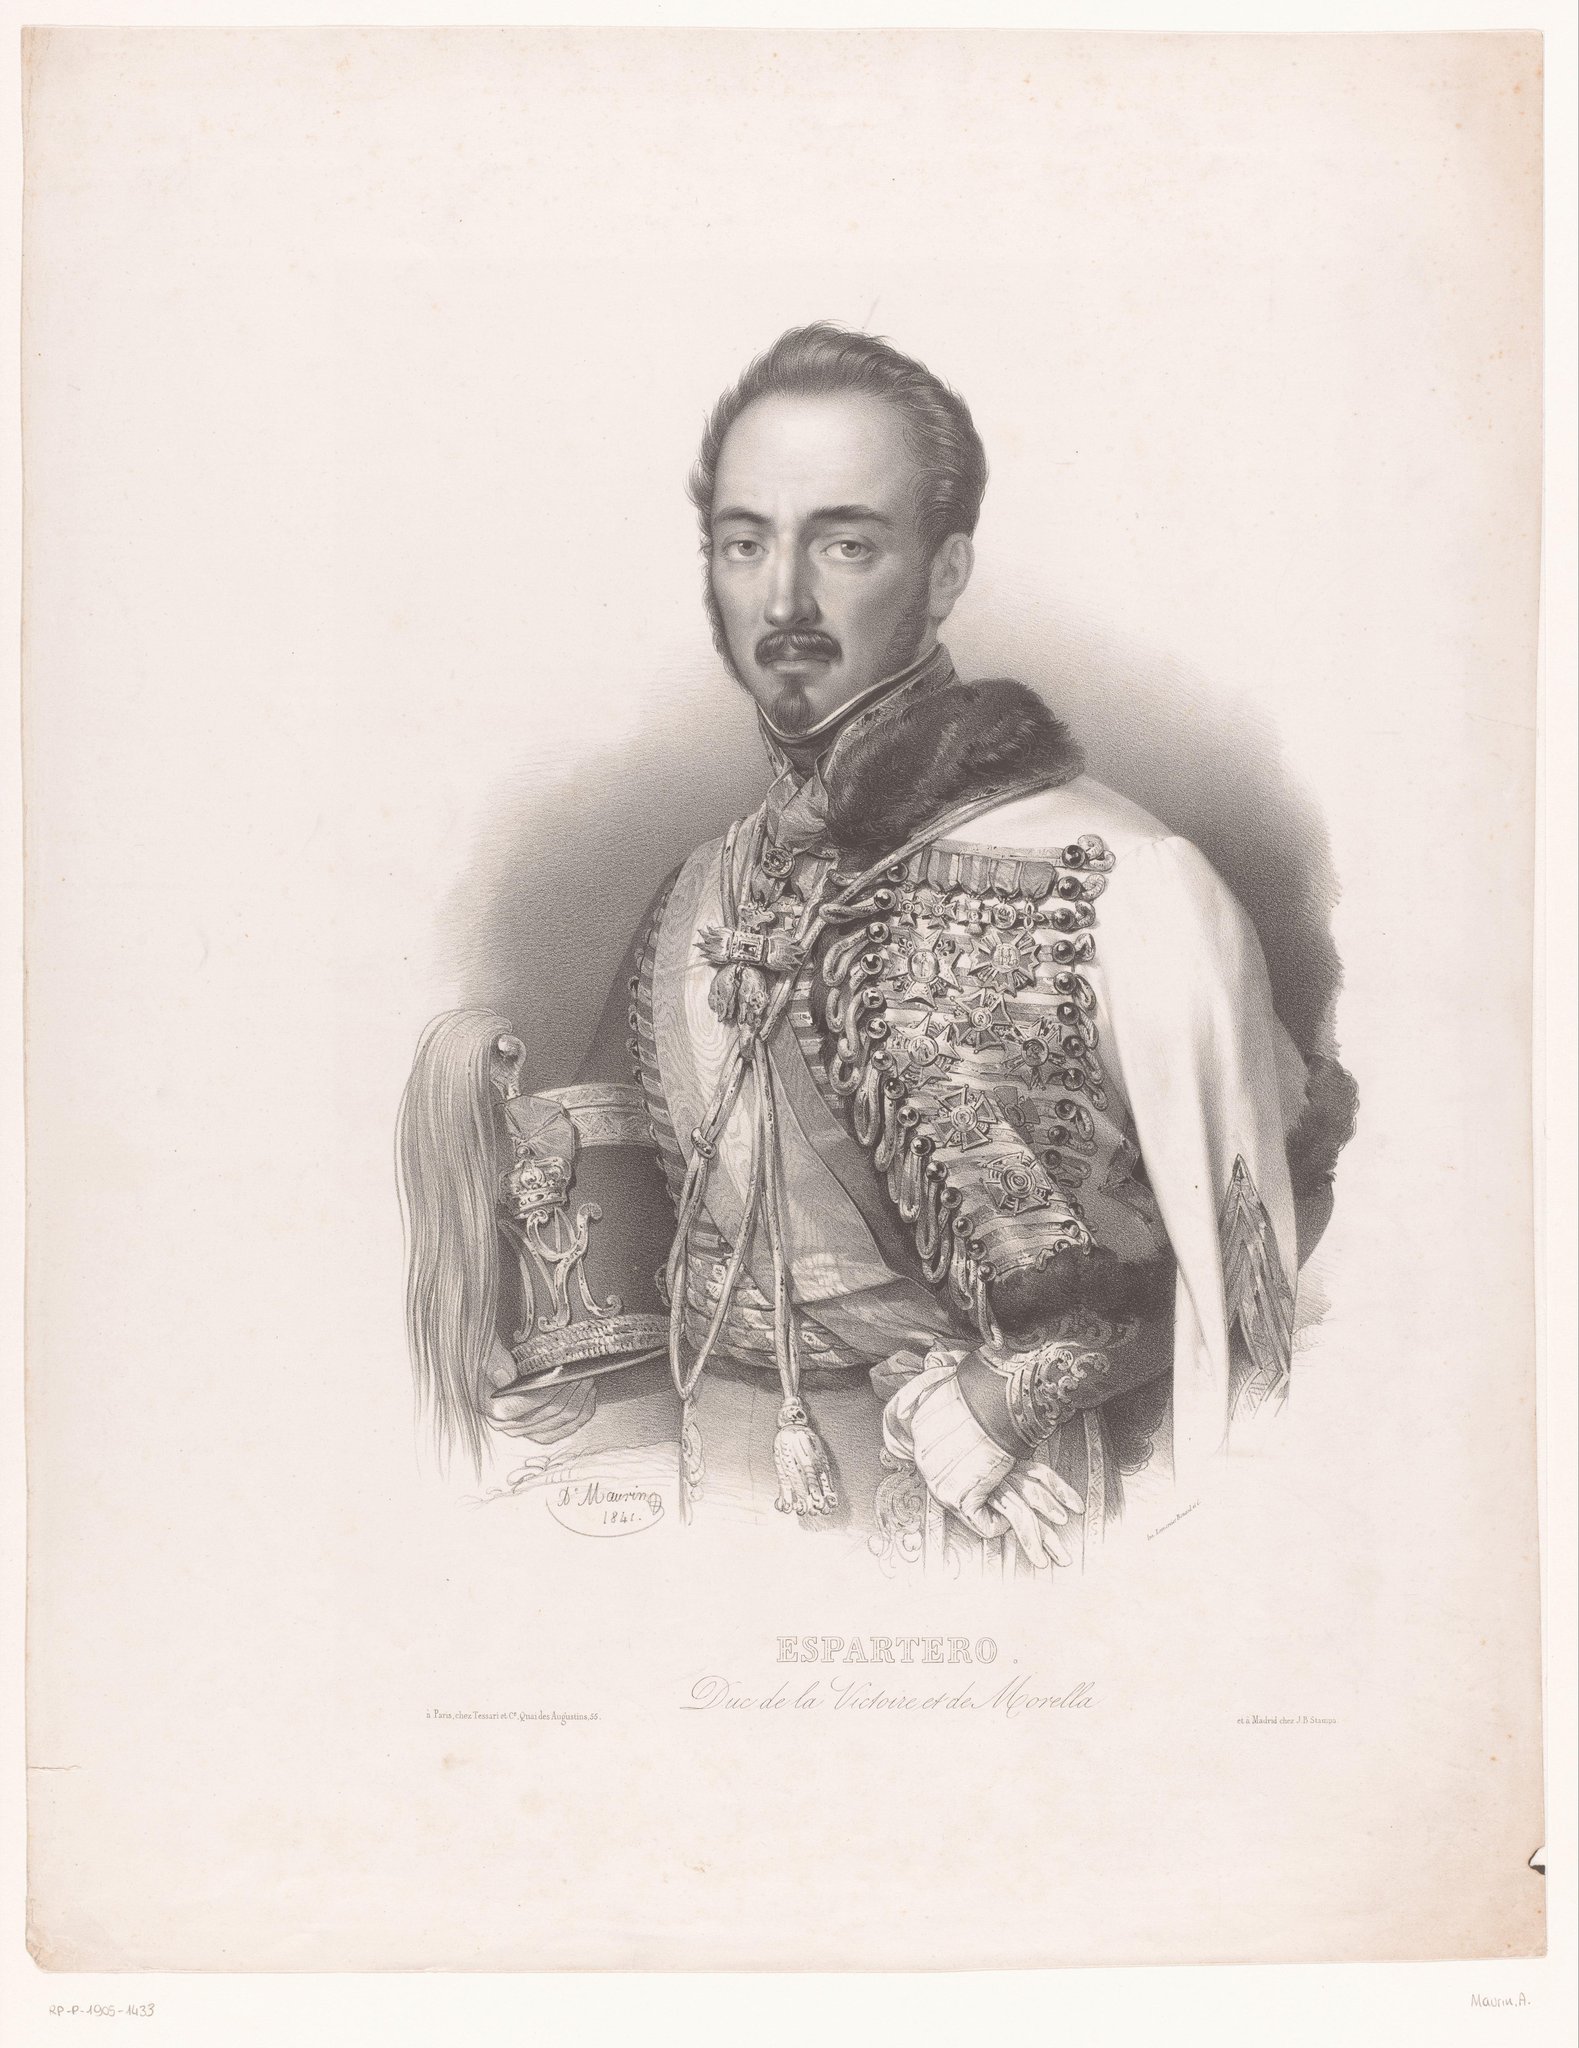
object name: print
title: Espartero, duc de la Victoire et de Morella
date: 1841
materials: paper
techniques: lithograph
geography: paris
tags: politician, historical persons, politician, e.g. party leader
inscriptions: collector's mark: Lugt 2228